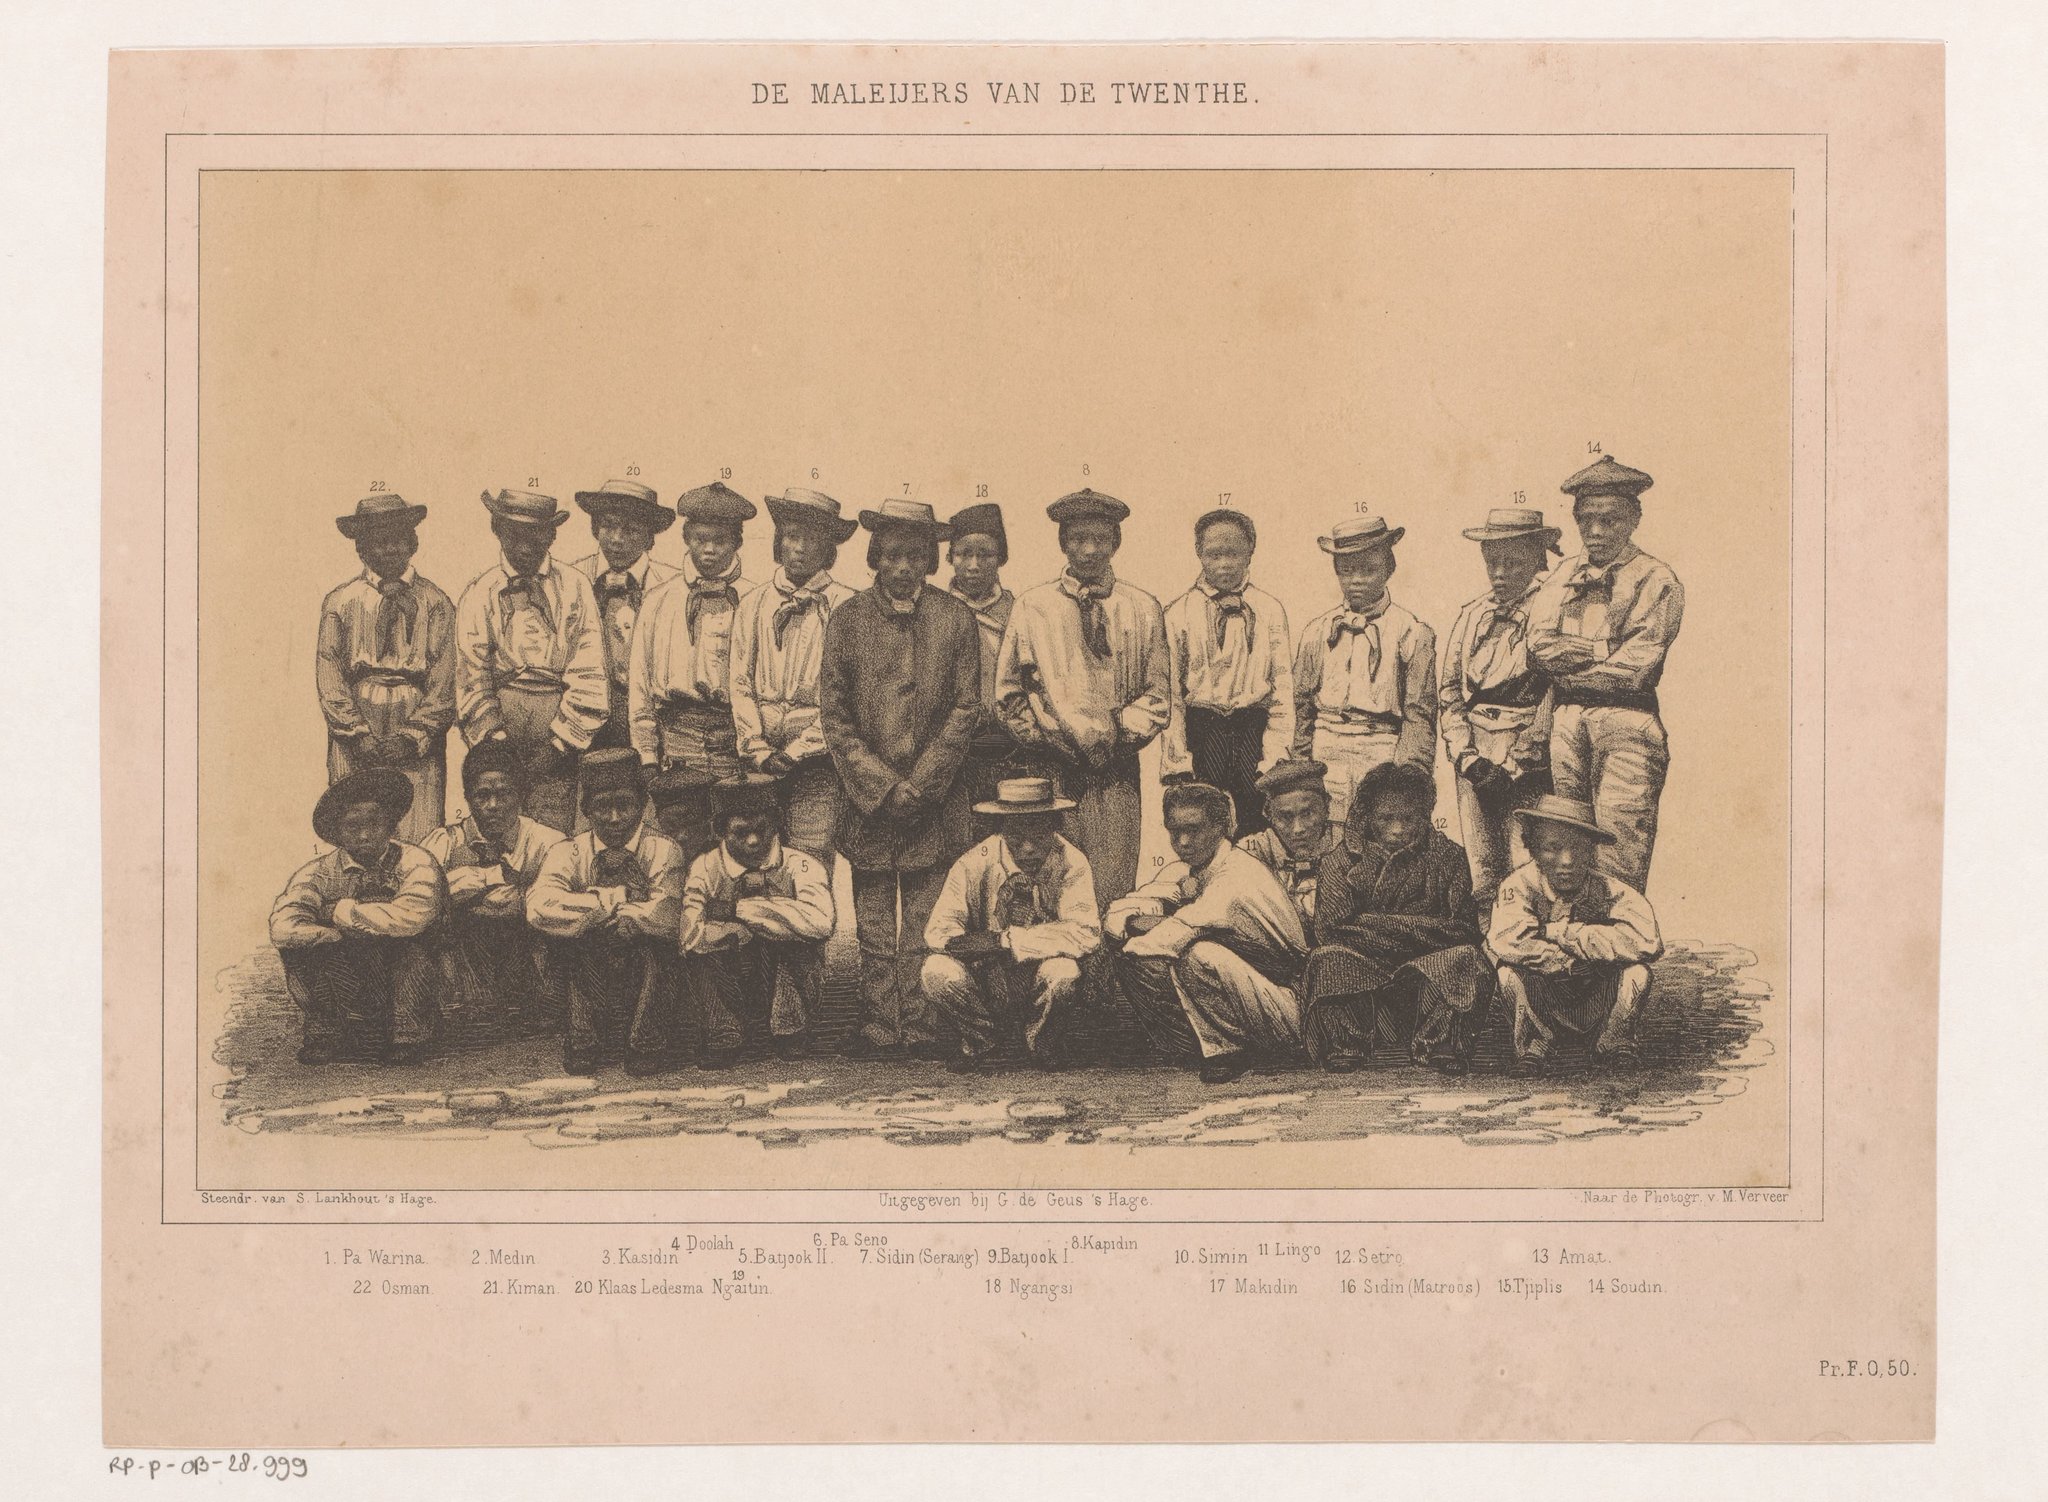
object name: print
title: Maleiers van het koopvaardijschip 'Twenthe'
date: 1858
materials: paper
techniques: tone lithography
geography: the hague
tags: the accused, historical person (with name) - historical person (with name) portrayed in a group, in a group-portrait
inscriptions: collector's mark: Lugt 2228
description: Groepsportret van de tweeëntwintig Maleiers van het koopvaardijschip 'Twenthe', die op 12 augustus 1856 op weg naar Oost-Indië muiterij pleegden en een deel van de bemanning vermoorden. Vier van hen werden op 1 maart 1858 tot tuchthuisstraf veroordeeld. Onderaan de namen 1-22.